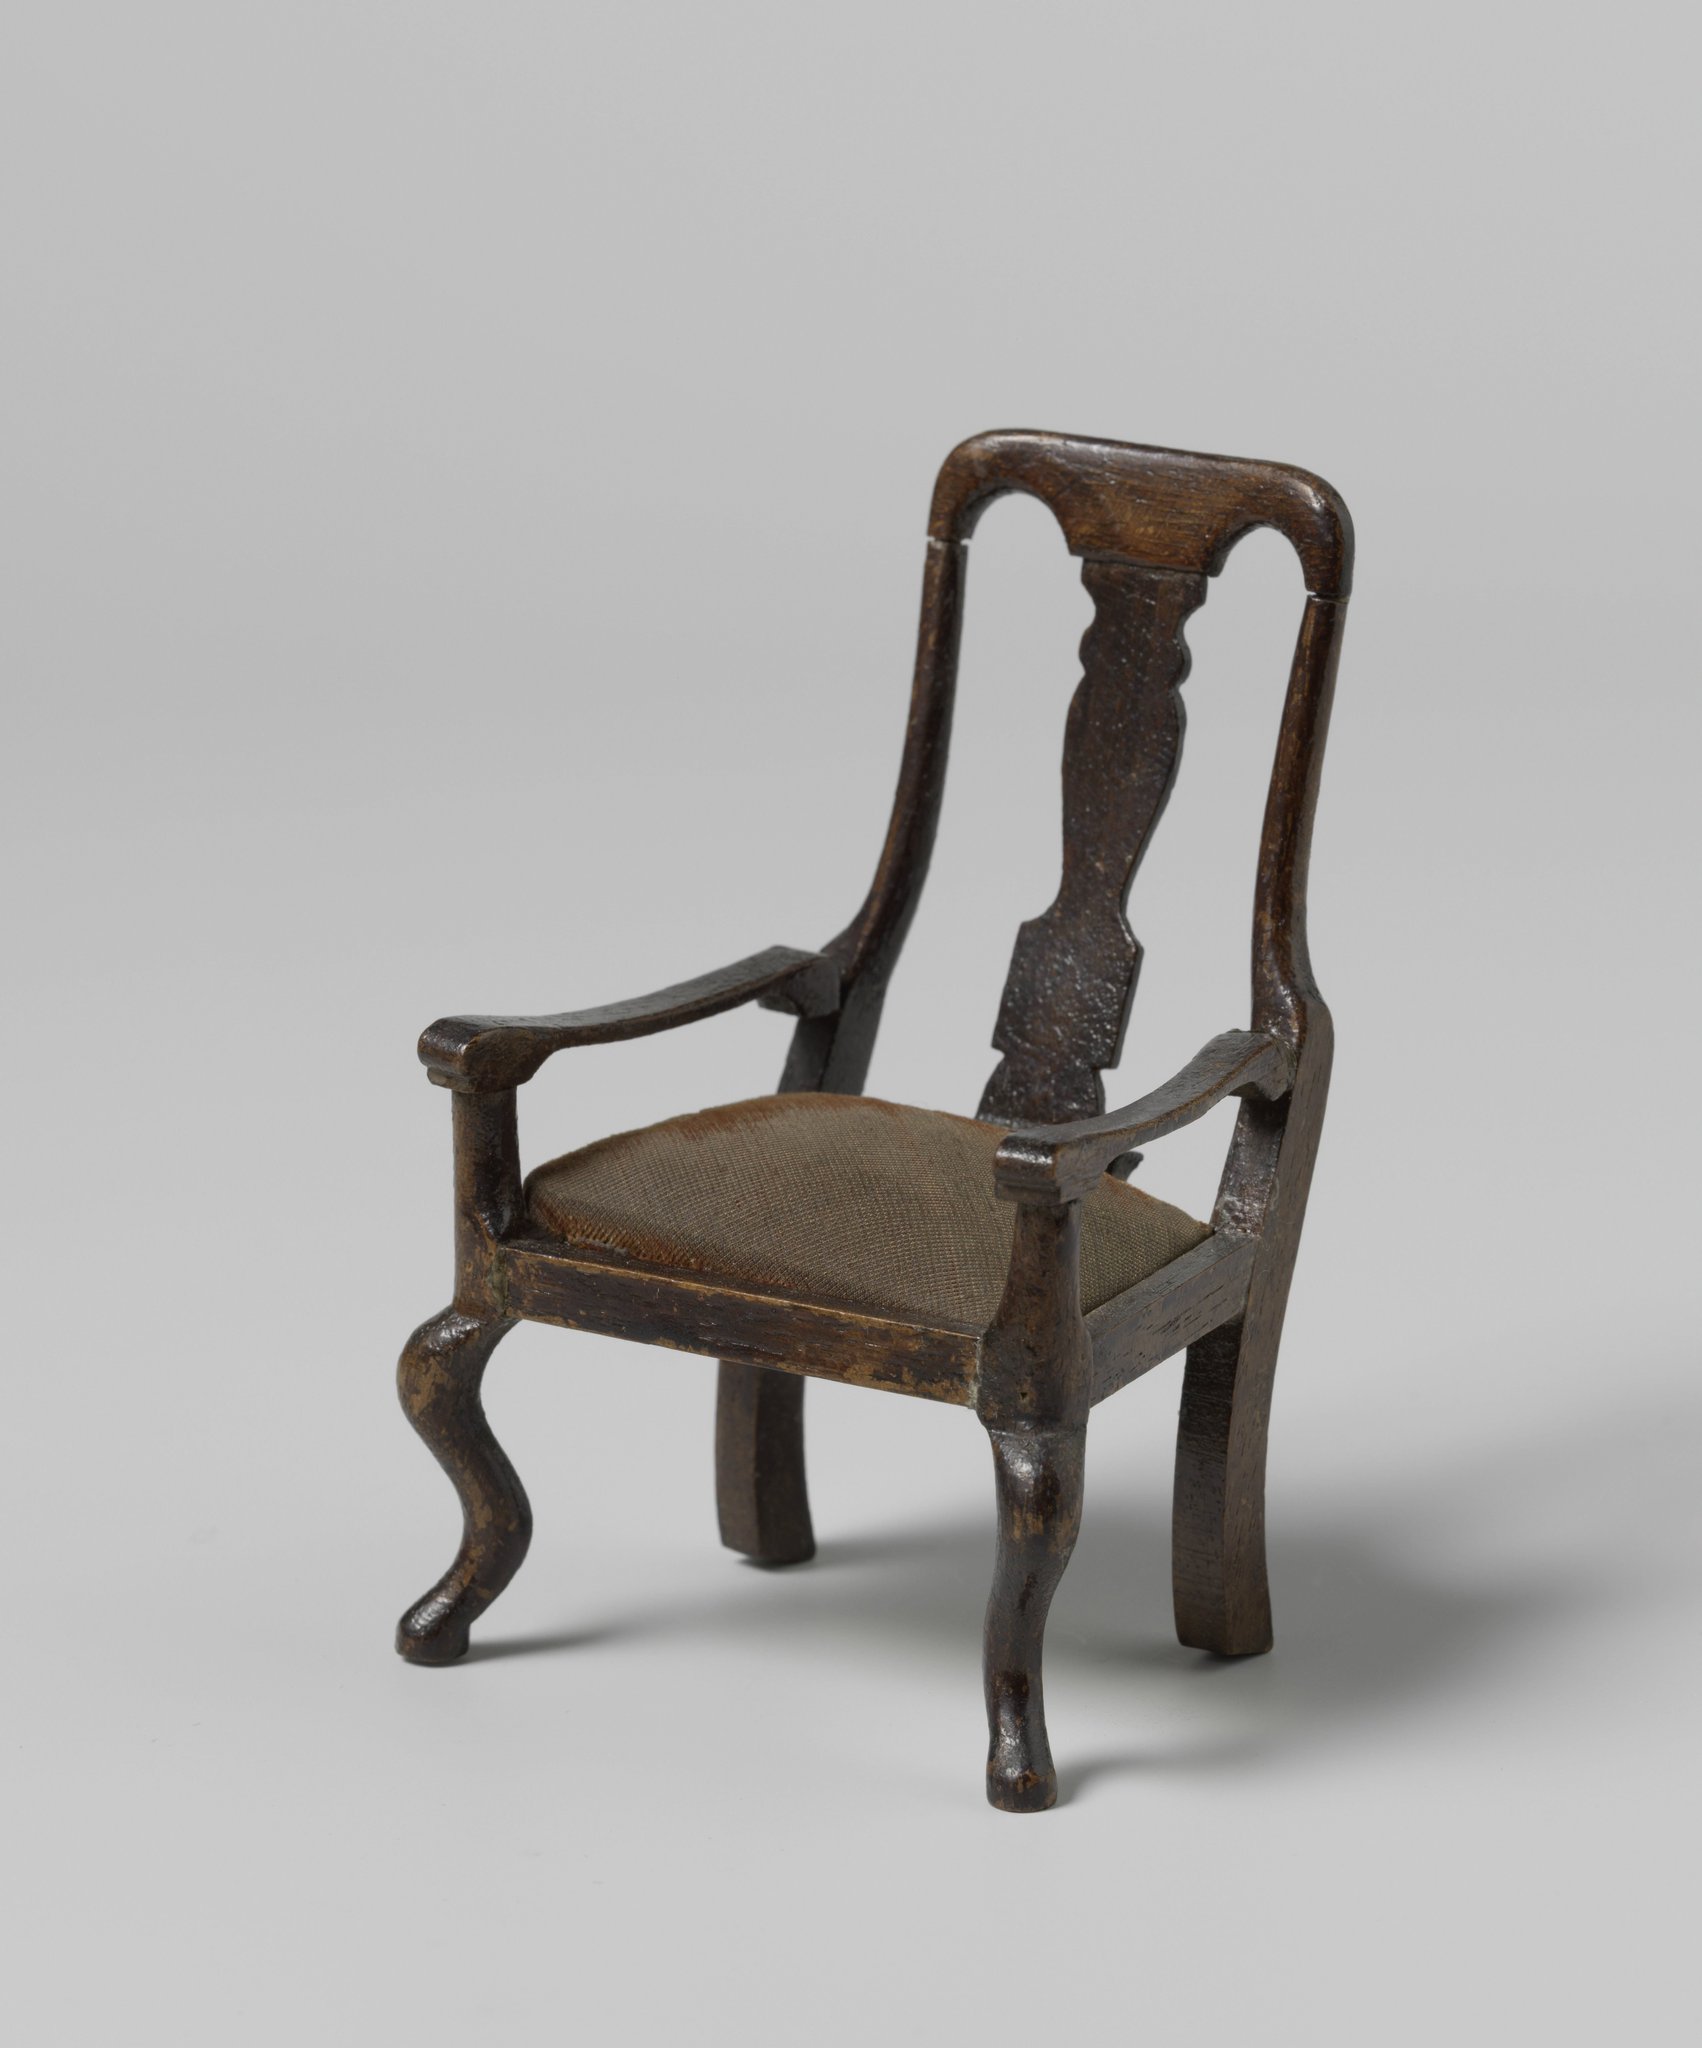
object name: armchair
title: Armstoel, de rug met vaasvormig middenblad, de zitting met bordeauxrode fluweel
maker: Anonymous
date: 1800-1899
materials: wood, velvet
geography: amsterdam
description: Armstoel van mahoniehout. De rug is open met een vaasvormig middenblad. De stoel heeft een trapezium-vormig open zitraam met losse zitting met bordeauxrode fluweel.